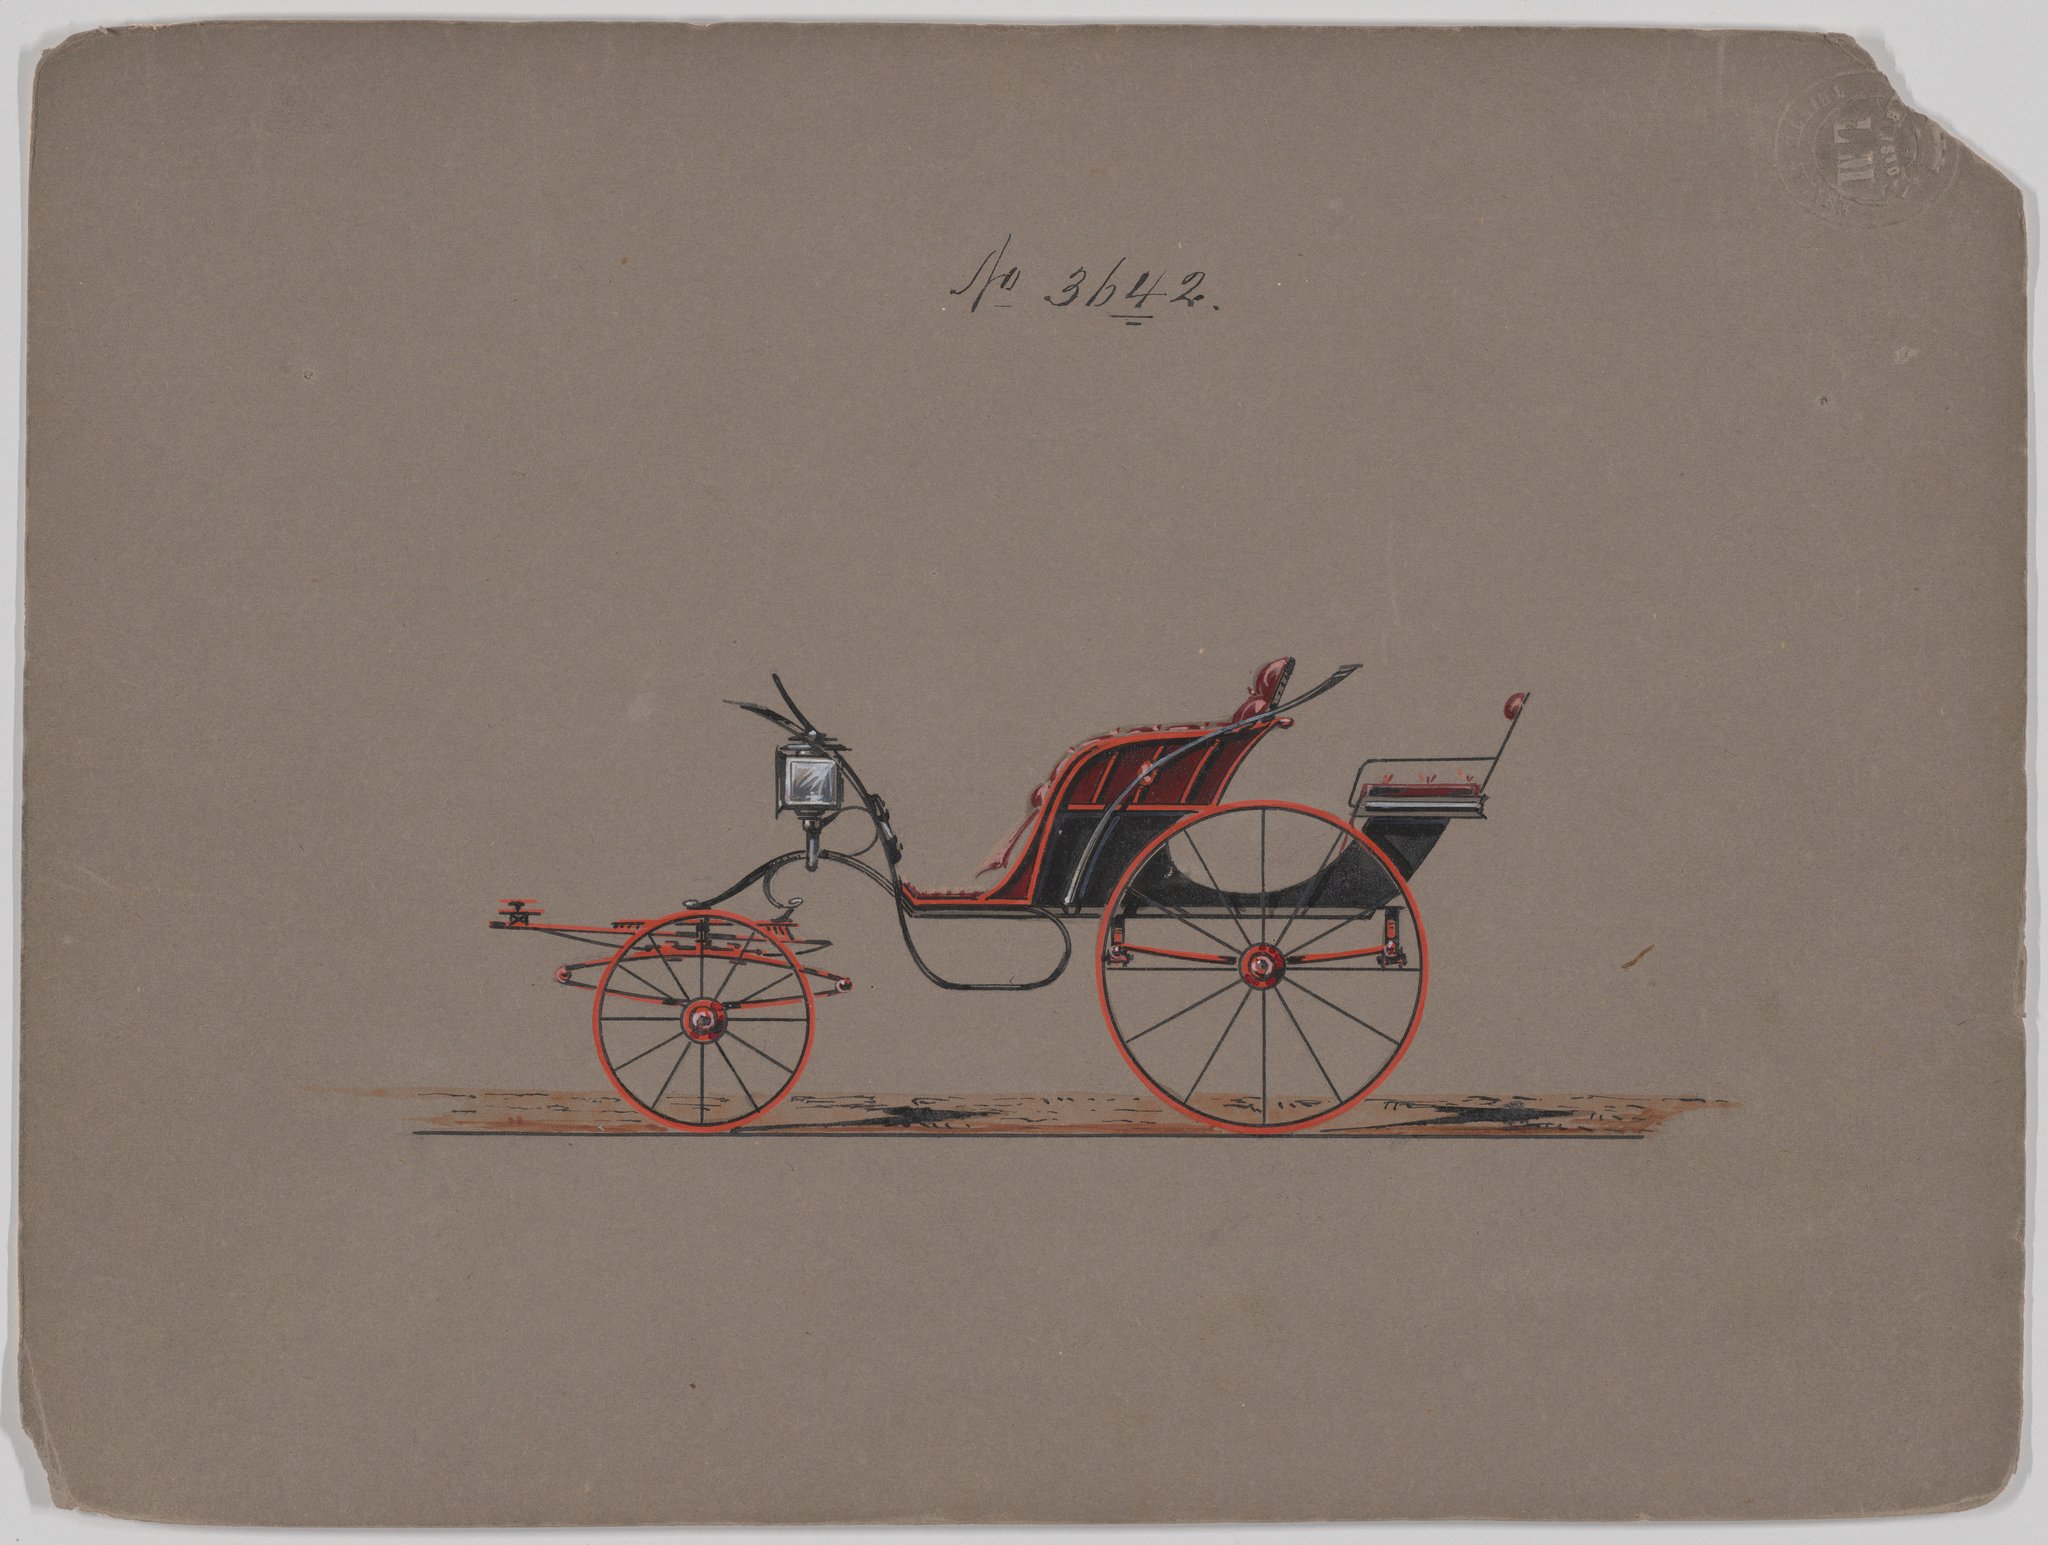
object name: drawing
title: Design for Pony Phaeton, no. 3642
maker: brewster & co.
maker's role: manufacturer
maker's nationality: american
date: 1880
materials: gouache, gum arabic, ink, watercolor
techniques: pen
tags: carriages